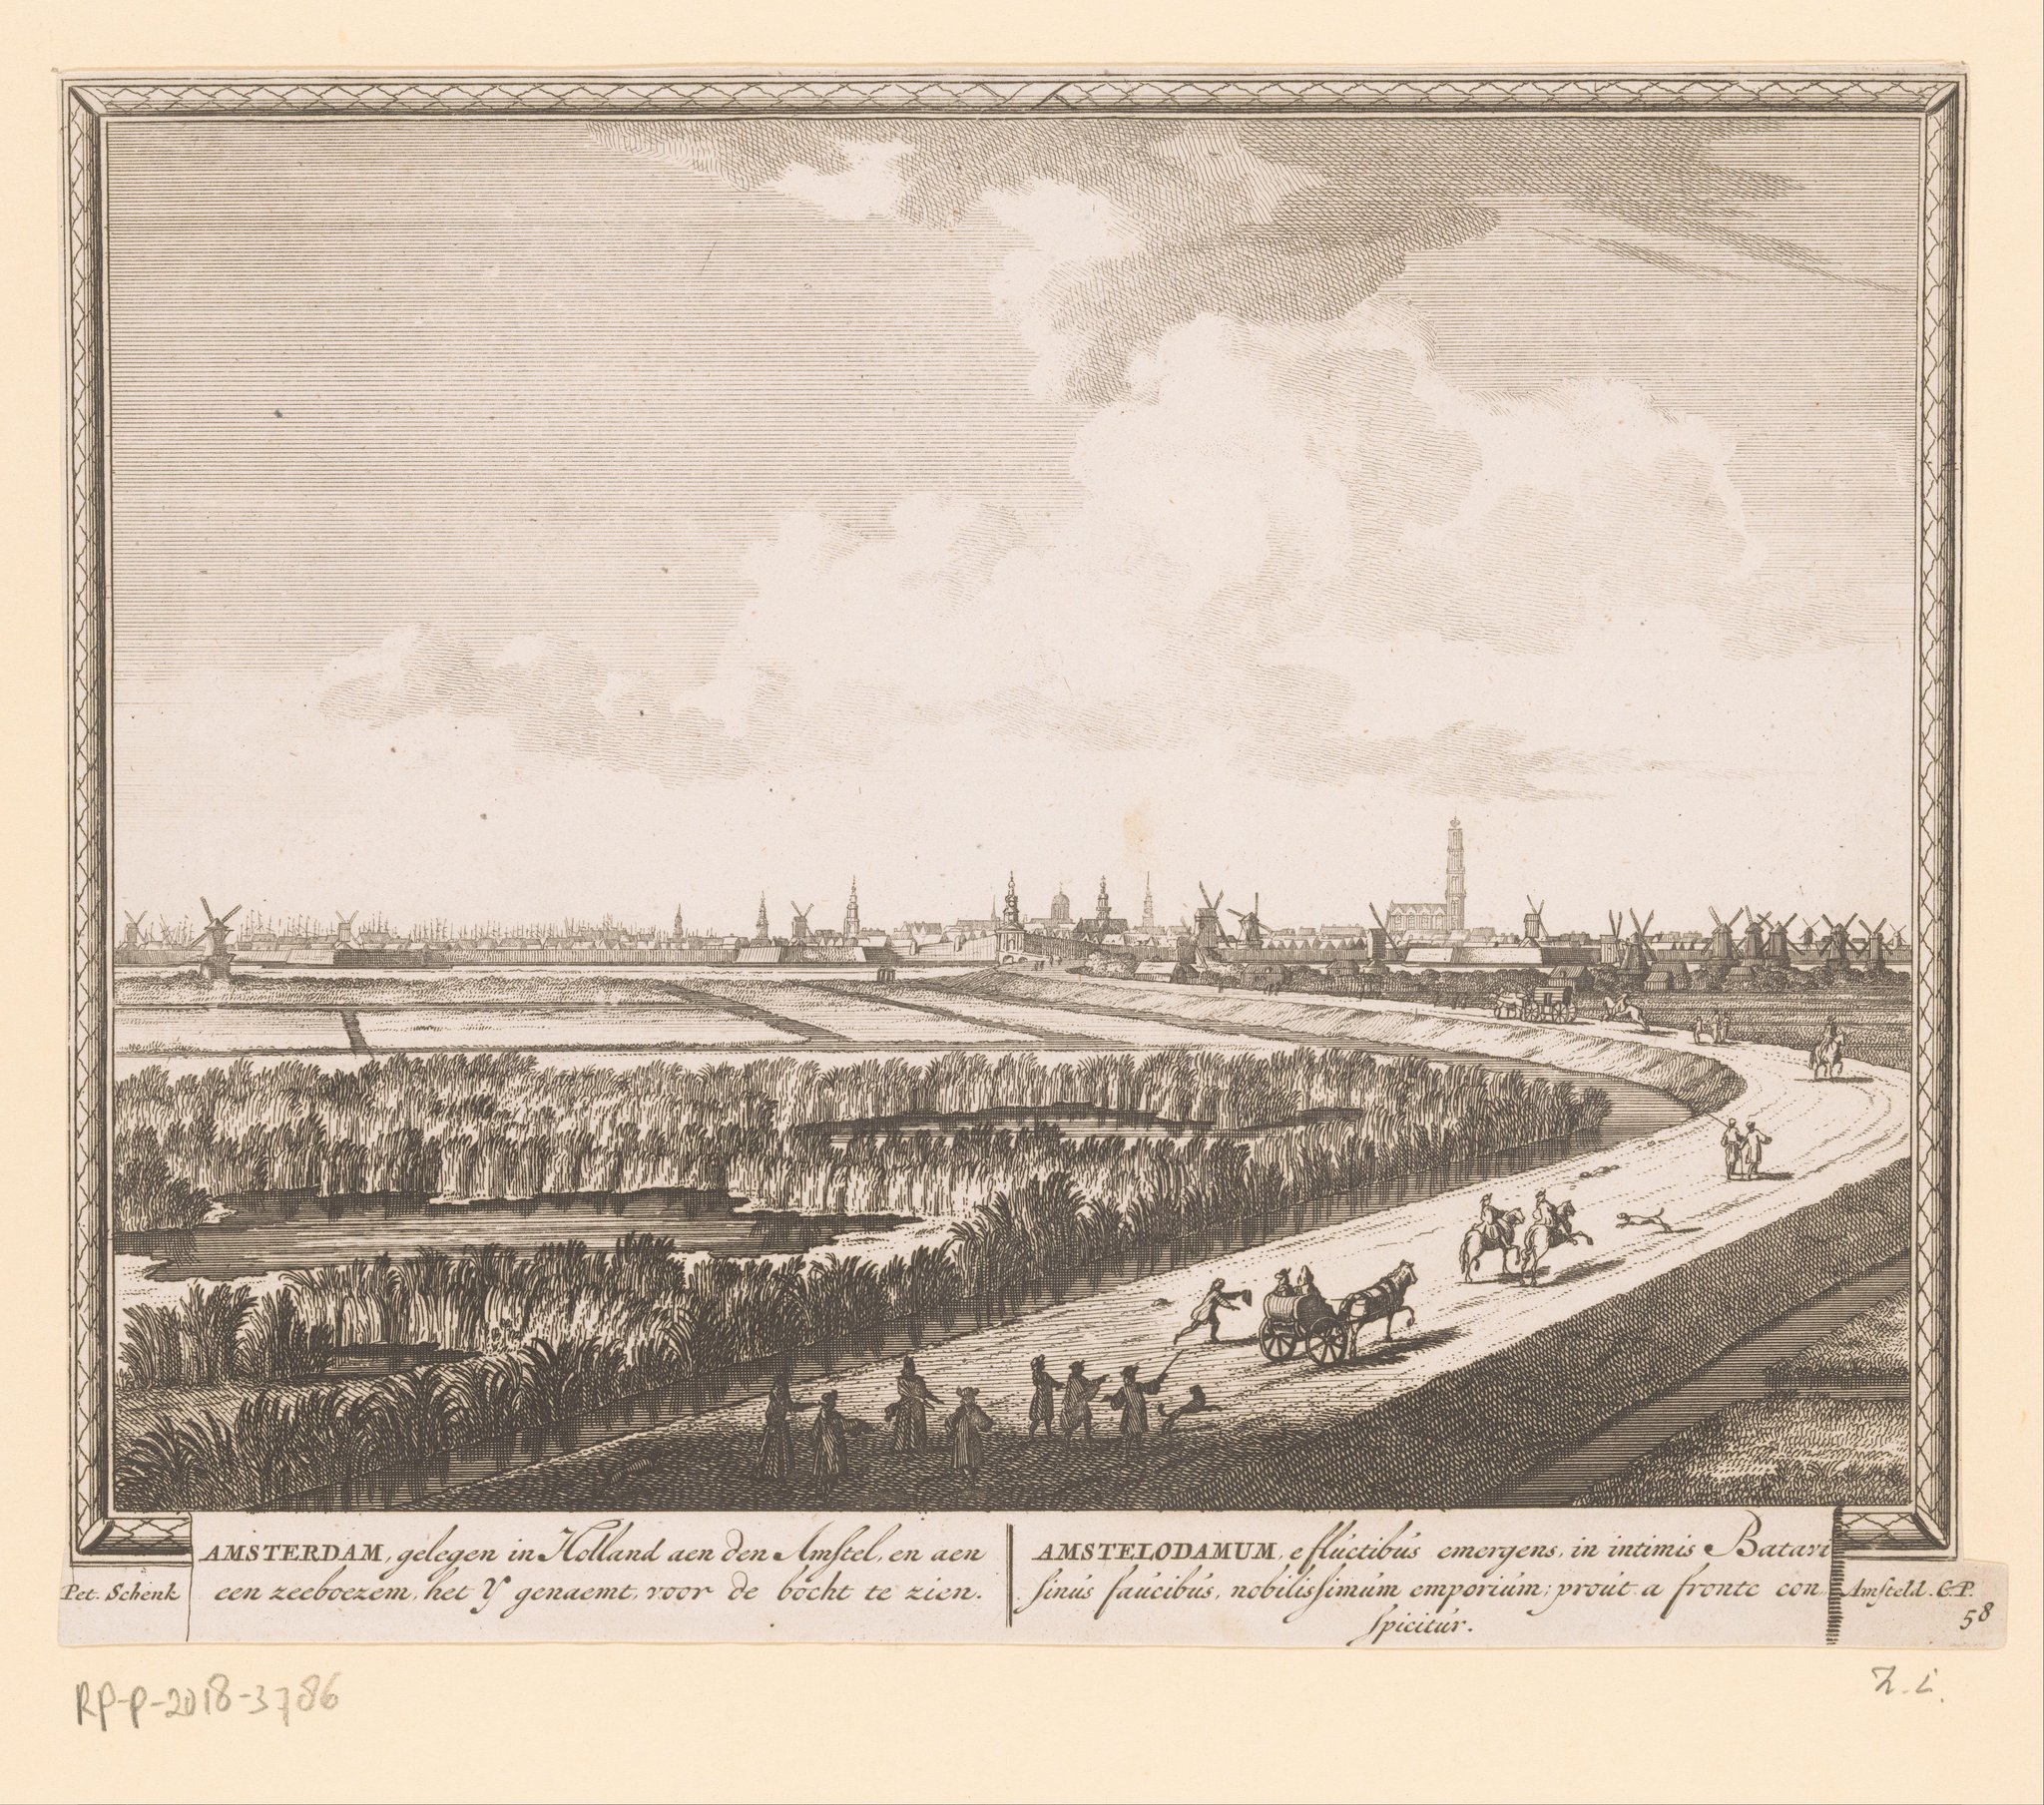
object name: print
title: Gezicht op Amsterdam vanaf de Spaarndammerdijk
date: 1675-1711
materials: paper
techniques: etching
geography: amsterdam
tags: city-view, and landscape with man-made constructions, road, path, amsterdam